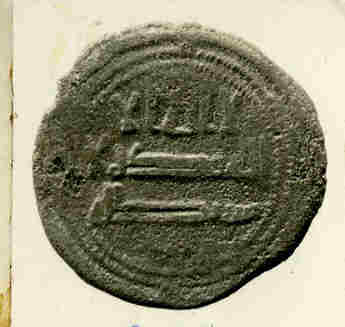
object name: coin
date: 701-800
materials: copper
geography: iran